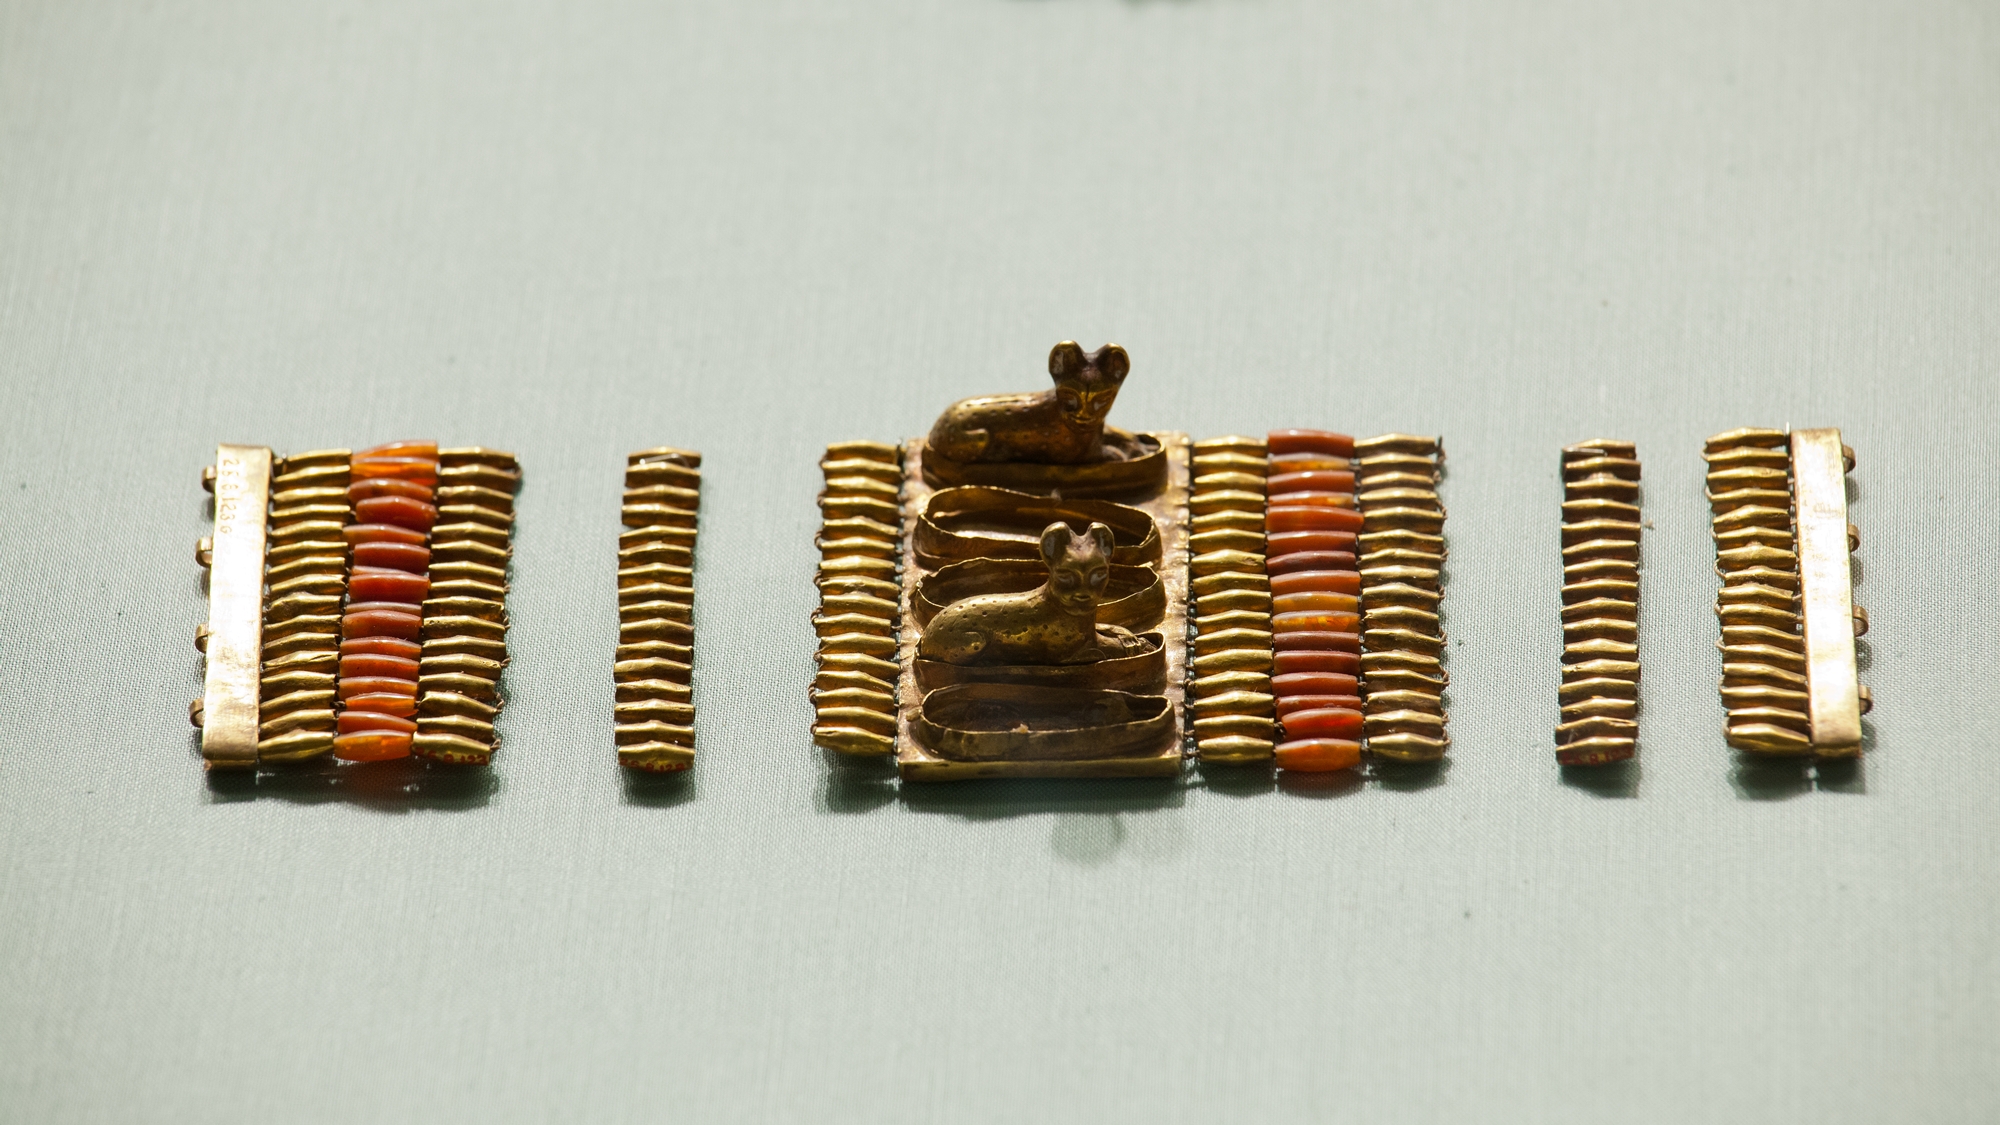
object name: bracelet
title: Cuff Bracelet with Lion Cub Amulets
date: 1479-1425 BCE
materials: gemstone, glass, gold, lapis lazuli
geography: egypt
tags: animals